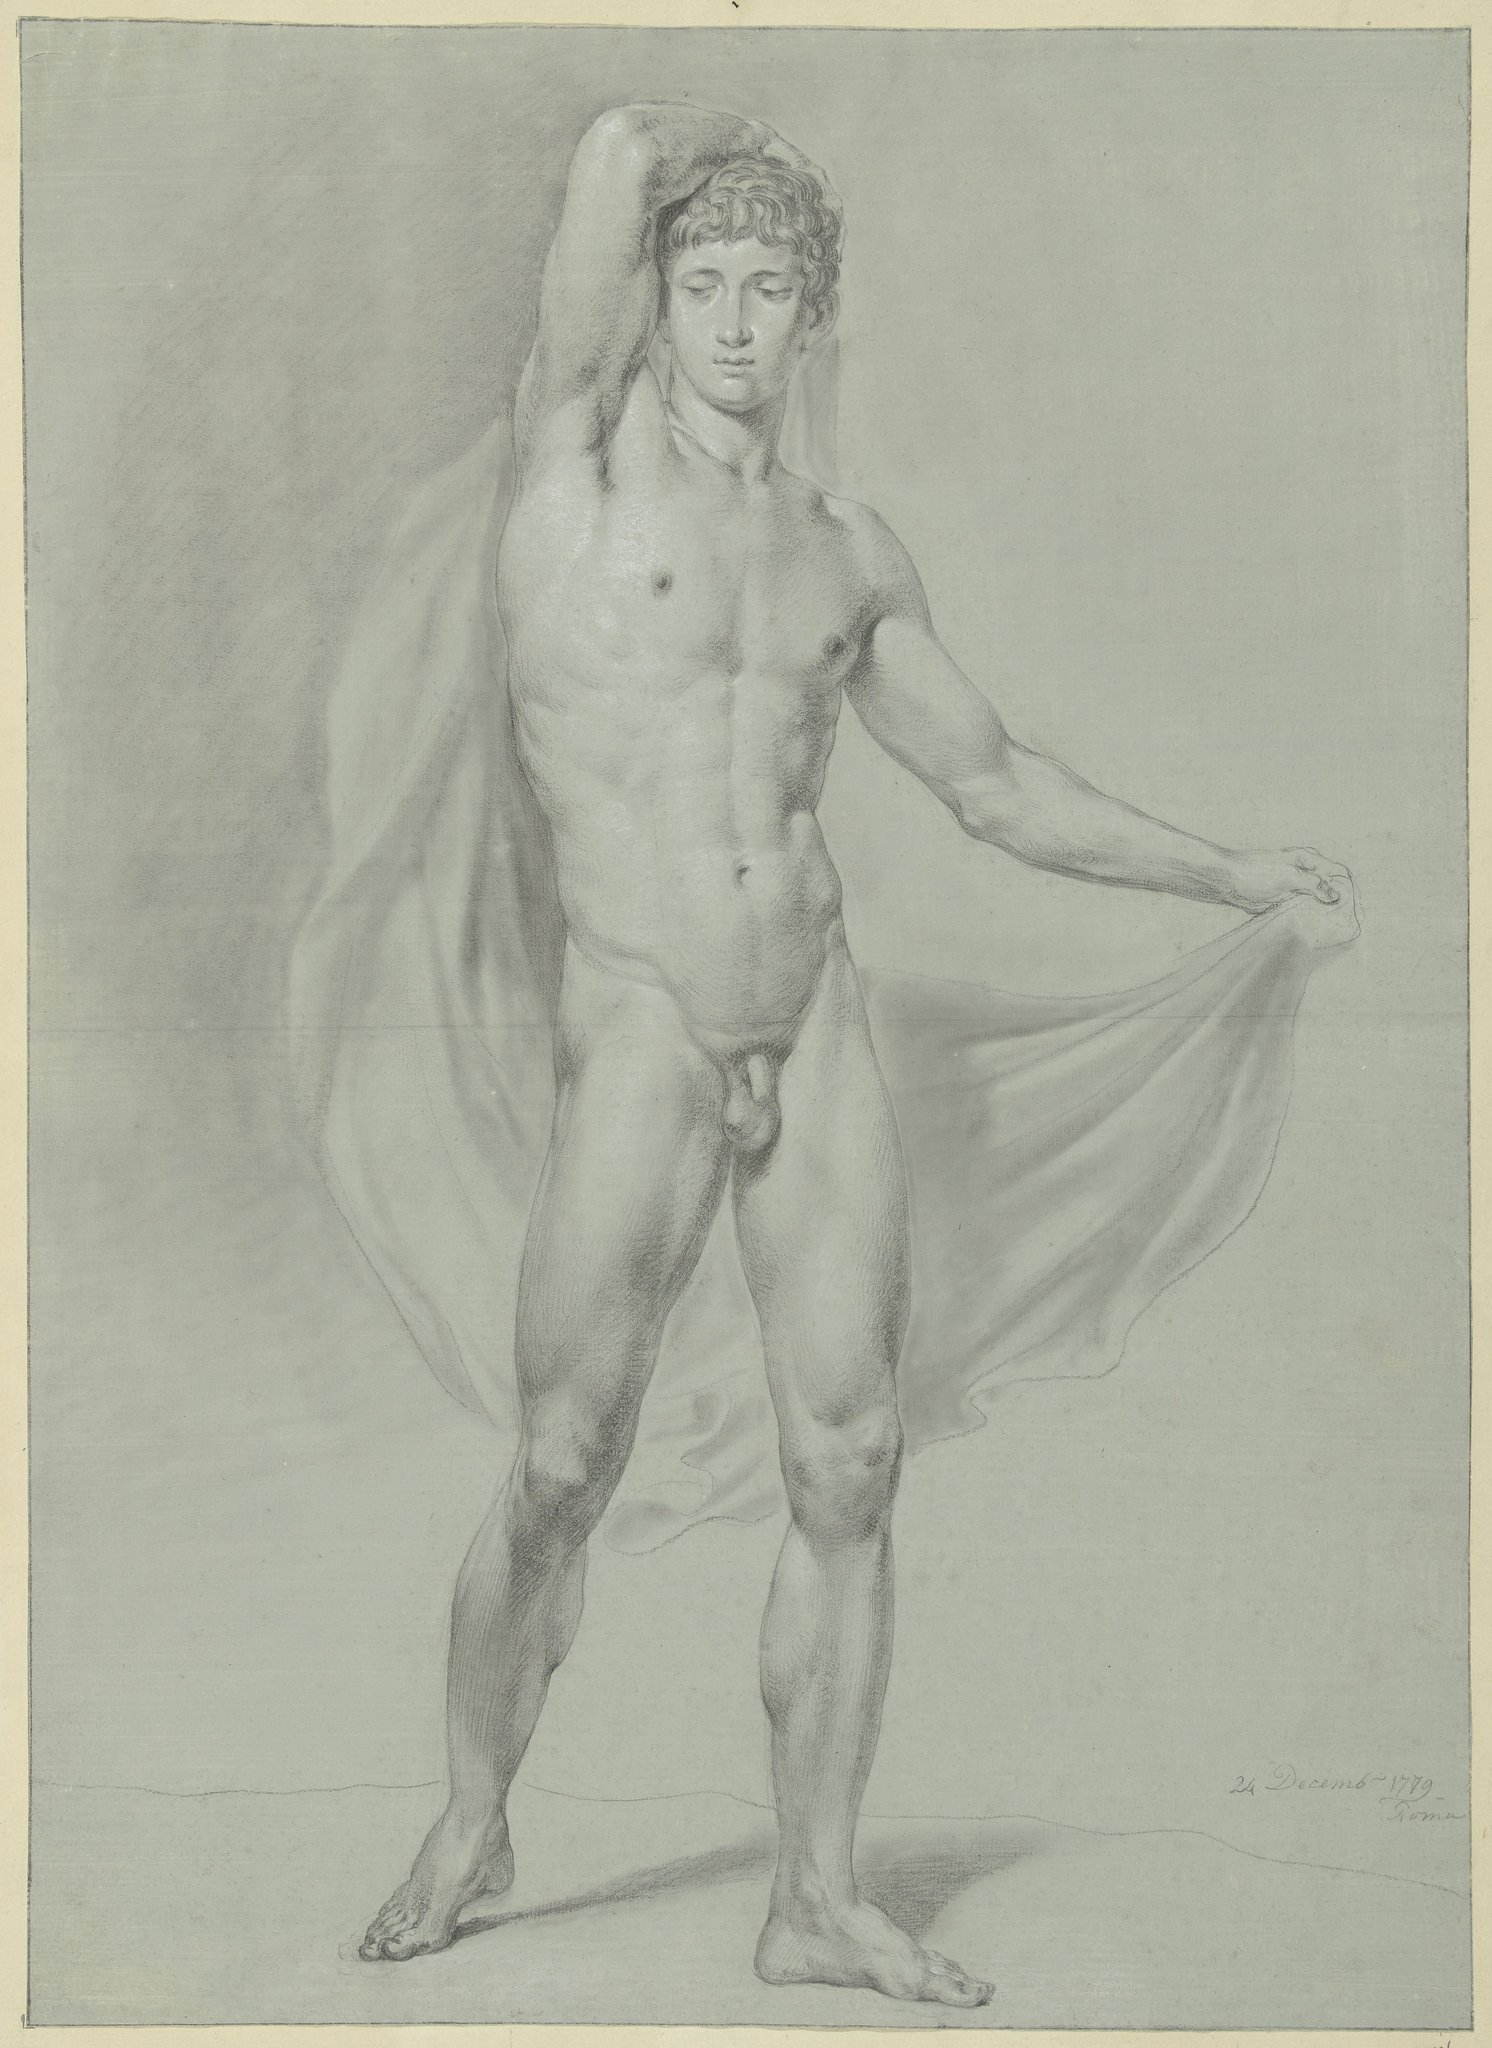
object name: drawing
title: Staand mannelijk naakt, met een doek achter de rug, van voren gezien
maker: jean grandjean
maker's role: draughtsman, print maker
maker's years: 1752-1781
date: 1779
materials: chalk, paper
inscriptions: date: ‘24 Decemb. 1779’